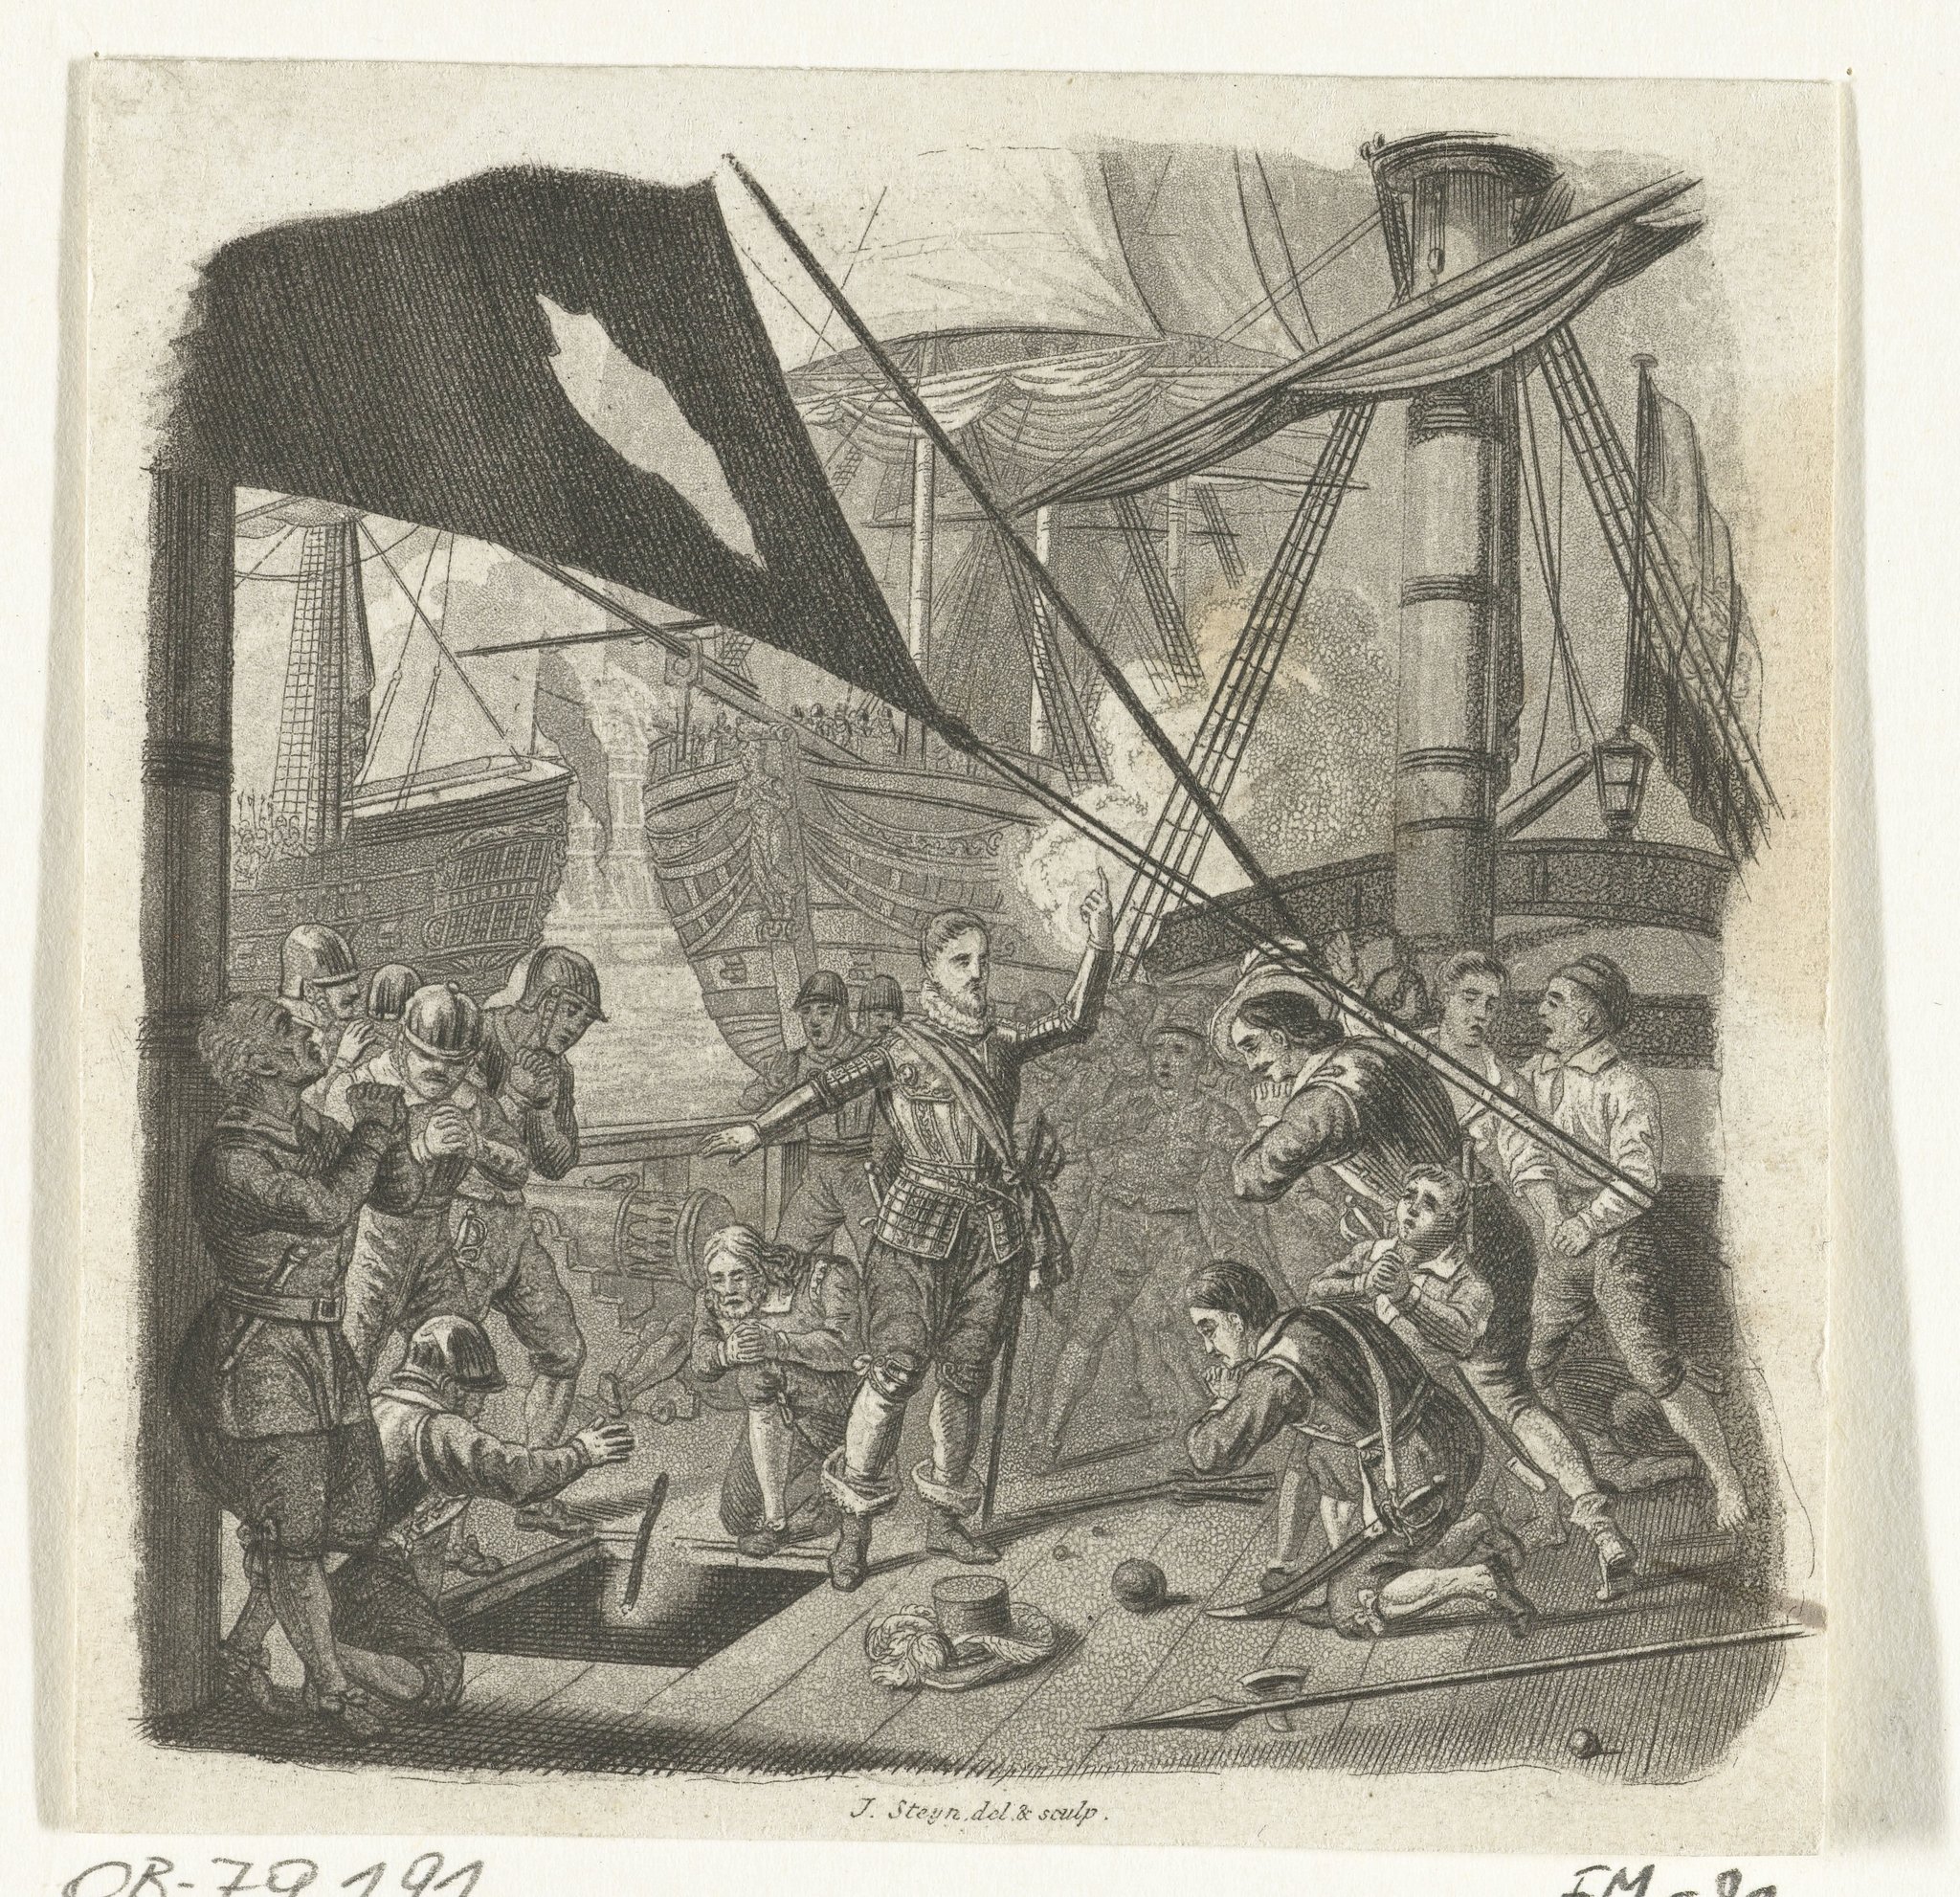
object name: history print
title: Sebastiaan de Lange blaast zijn schip en zichzelf op, 1572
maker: johannes steyn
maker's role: print maker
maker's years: 1805-1840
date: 1835-1837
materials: paper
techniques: aquatint, engraving, etching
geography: netherlands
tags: self-sacrifice, death in the service of a higher purpose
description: Sebastiaan de Lange, admiraal van Veere, steekt na een ongelijke strijd met vier Spaanse schepen bij het Sloe de brandende lont in het kruitmagazijn van zijn schip, 22 mei 1572. De admiraal staande op het dek omringd door zijn manschappen.